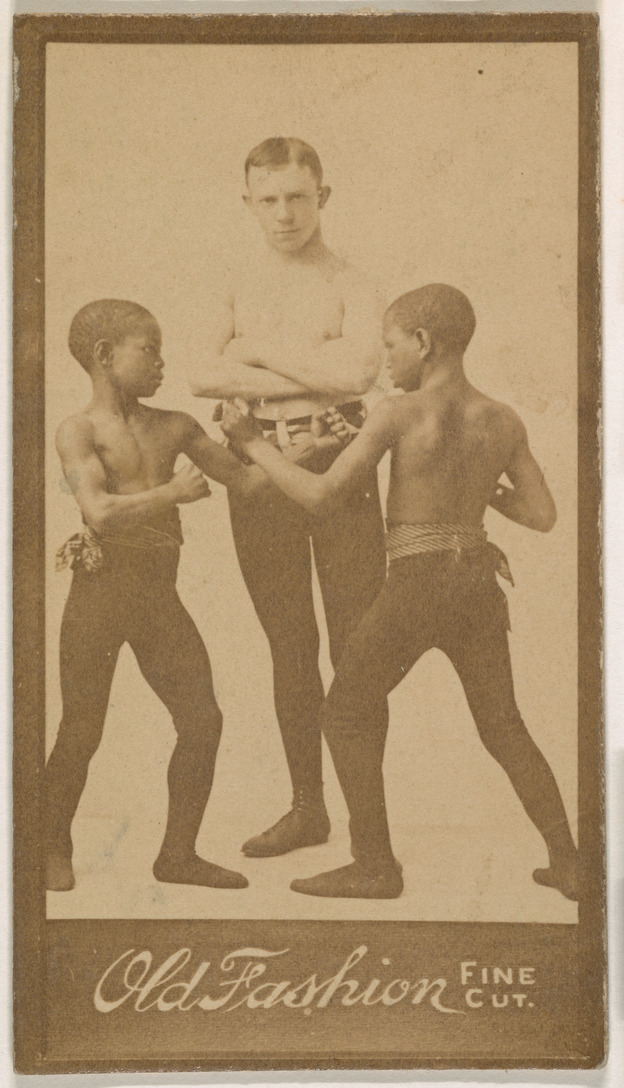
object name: photograph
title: Man standing with two children boxing, from the "Negro Subjects" series (N692) promoting Old Fashion Fine Cut Tobacco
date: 1888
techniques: albumen silver print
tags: boys,men,portraits,boxing,athletes